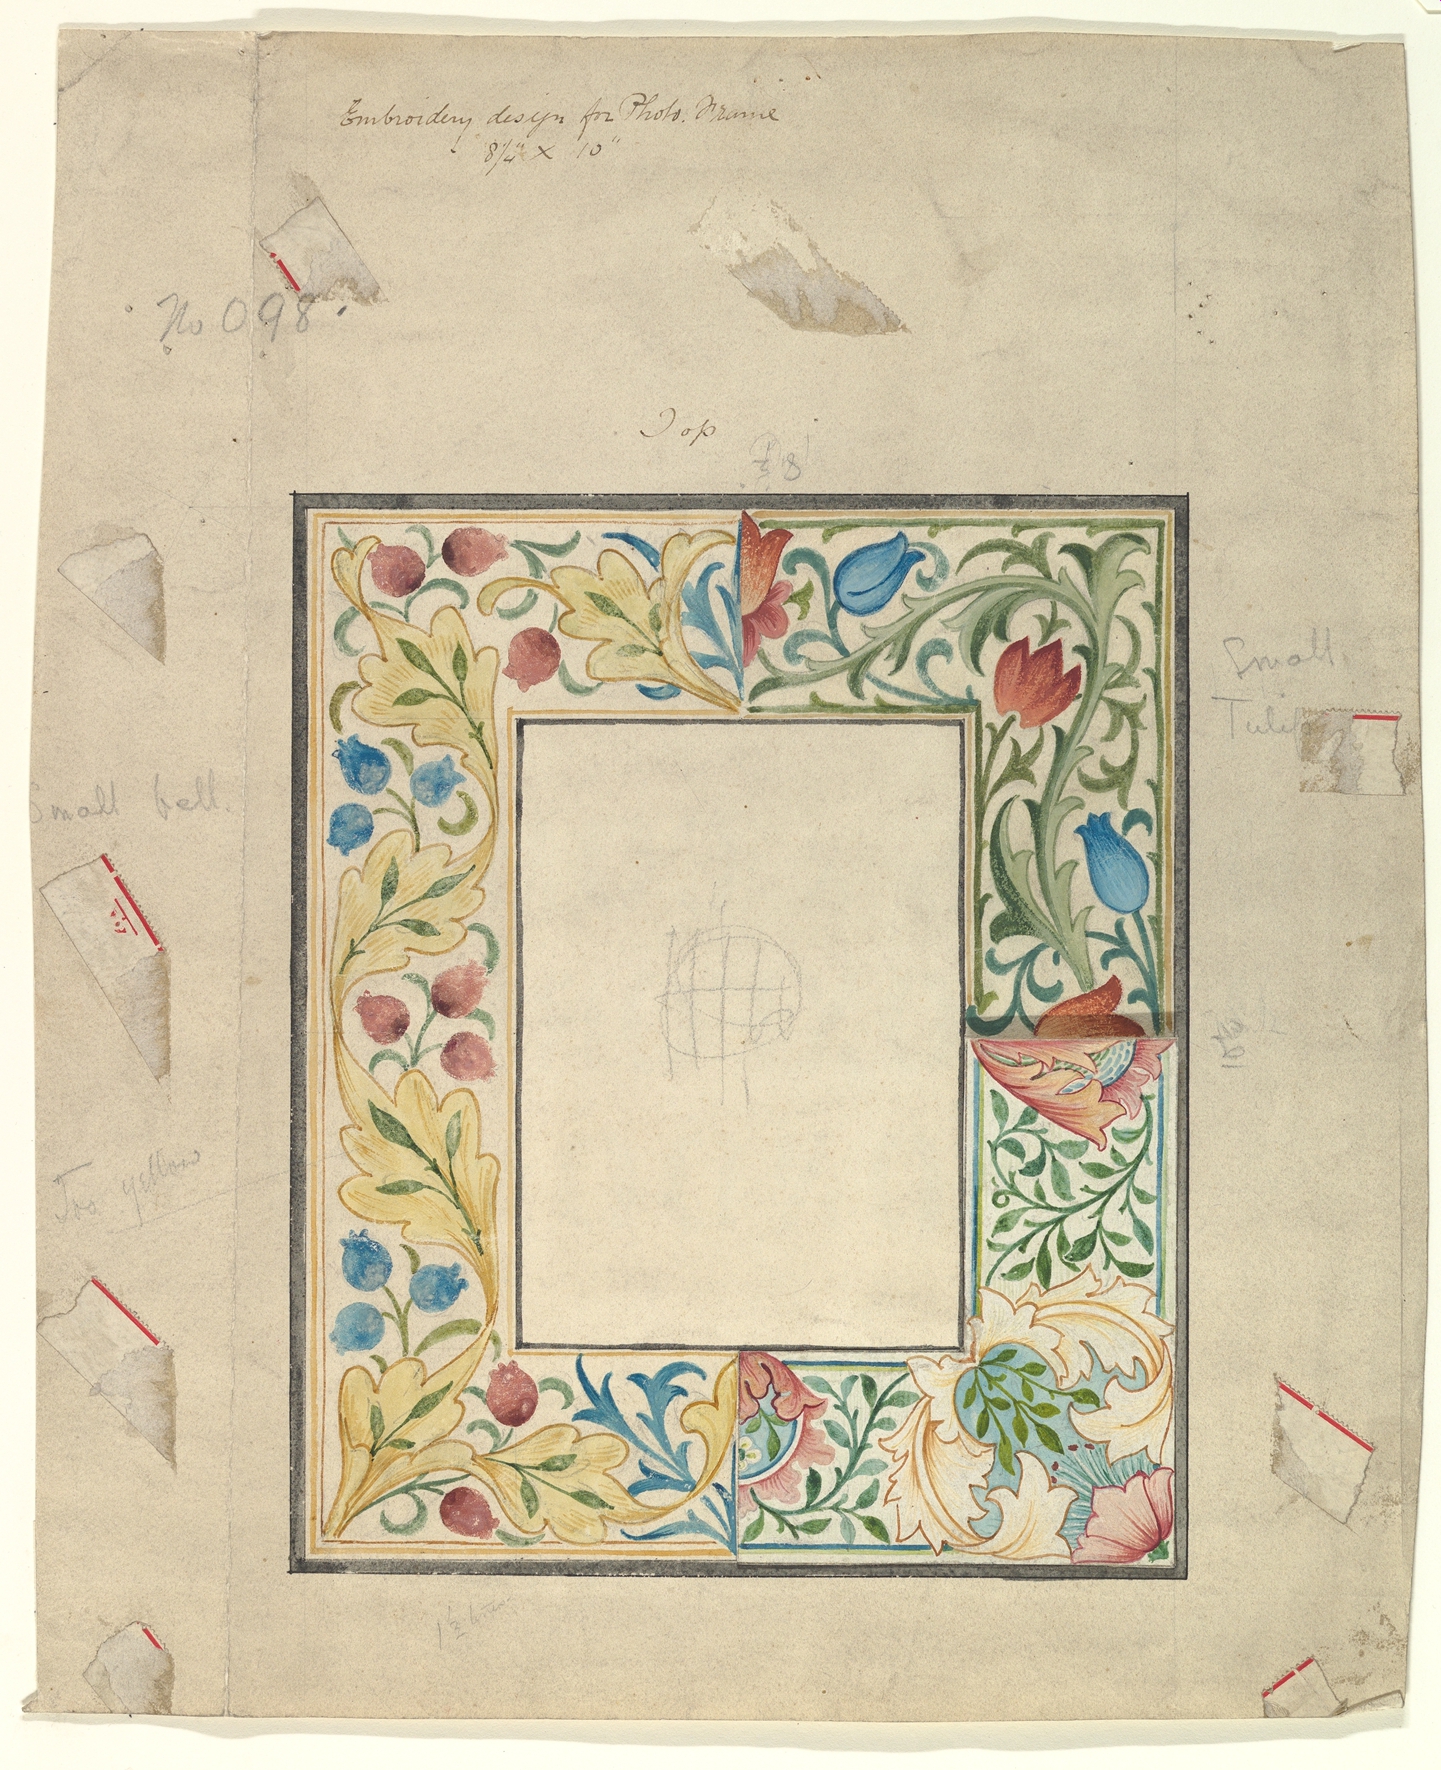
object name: drawing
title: Embroidery Design for a Frame, No. 098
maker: morris & company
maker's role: artist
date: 1875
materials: watercolor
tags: flowers